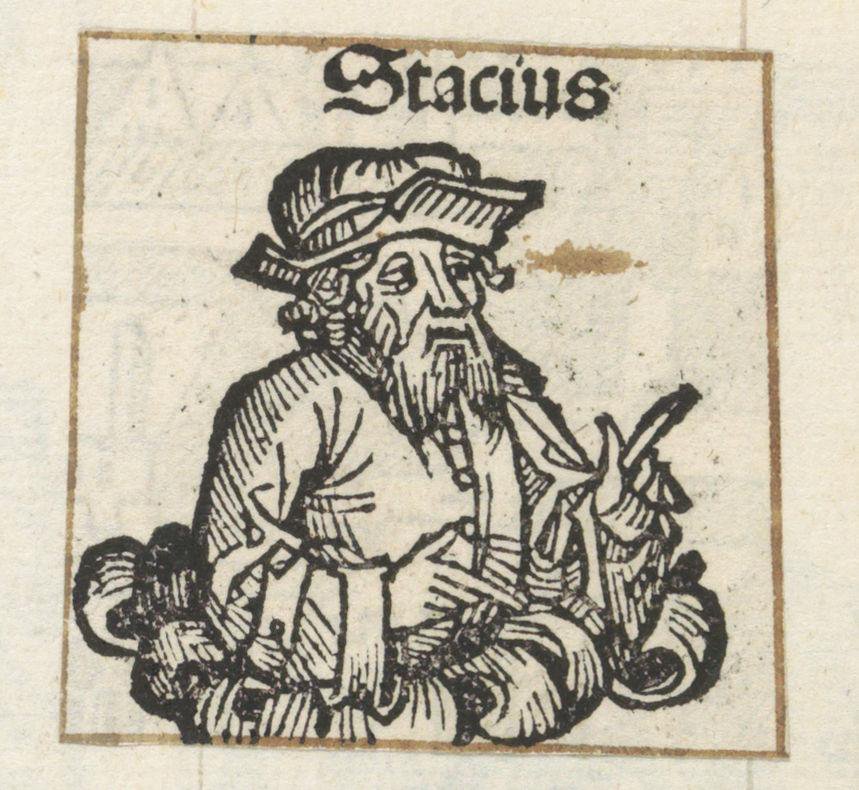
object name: album leaf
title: Publius Papinius Statius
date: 1493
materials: paper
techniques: letterpress printing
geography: nuremberg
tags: male persons from classical history, writer, poet, author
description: De houtsnede wordt gebruikt als boekillustratie in de Liber Chronicarum (of Neurenbergkroniek) van Hartmann Schedel, verschenen in het Latijn en Duits in 1493. Zie de Latijnse uitgave, folio 110r.